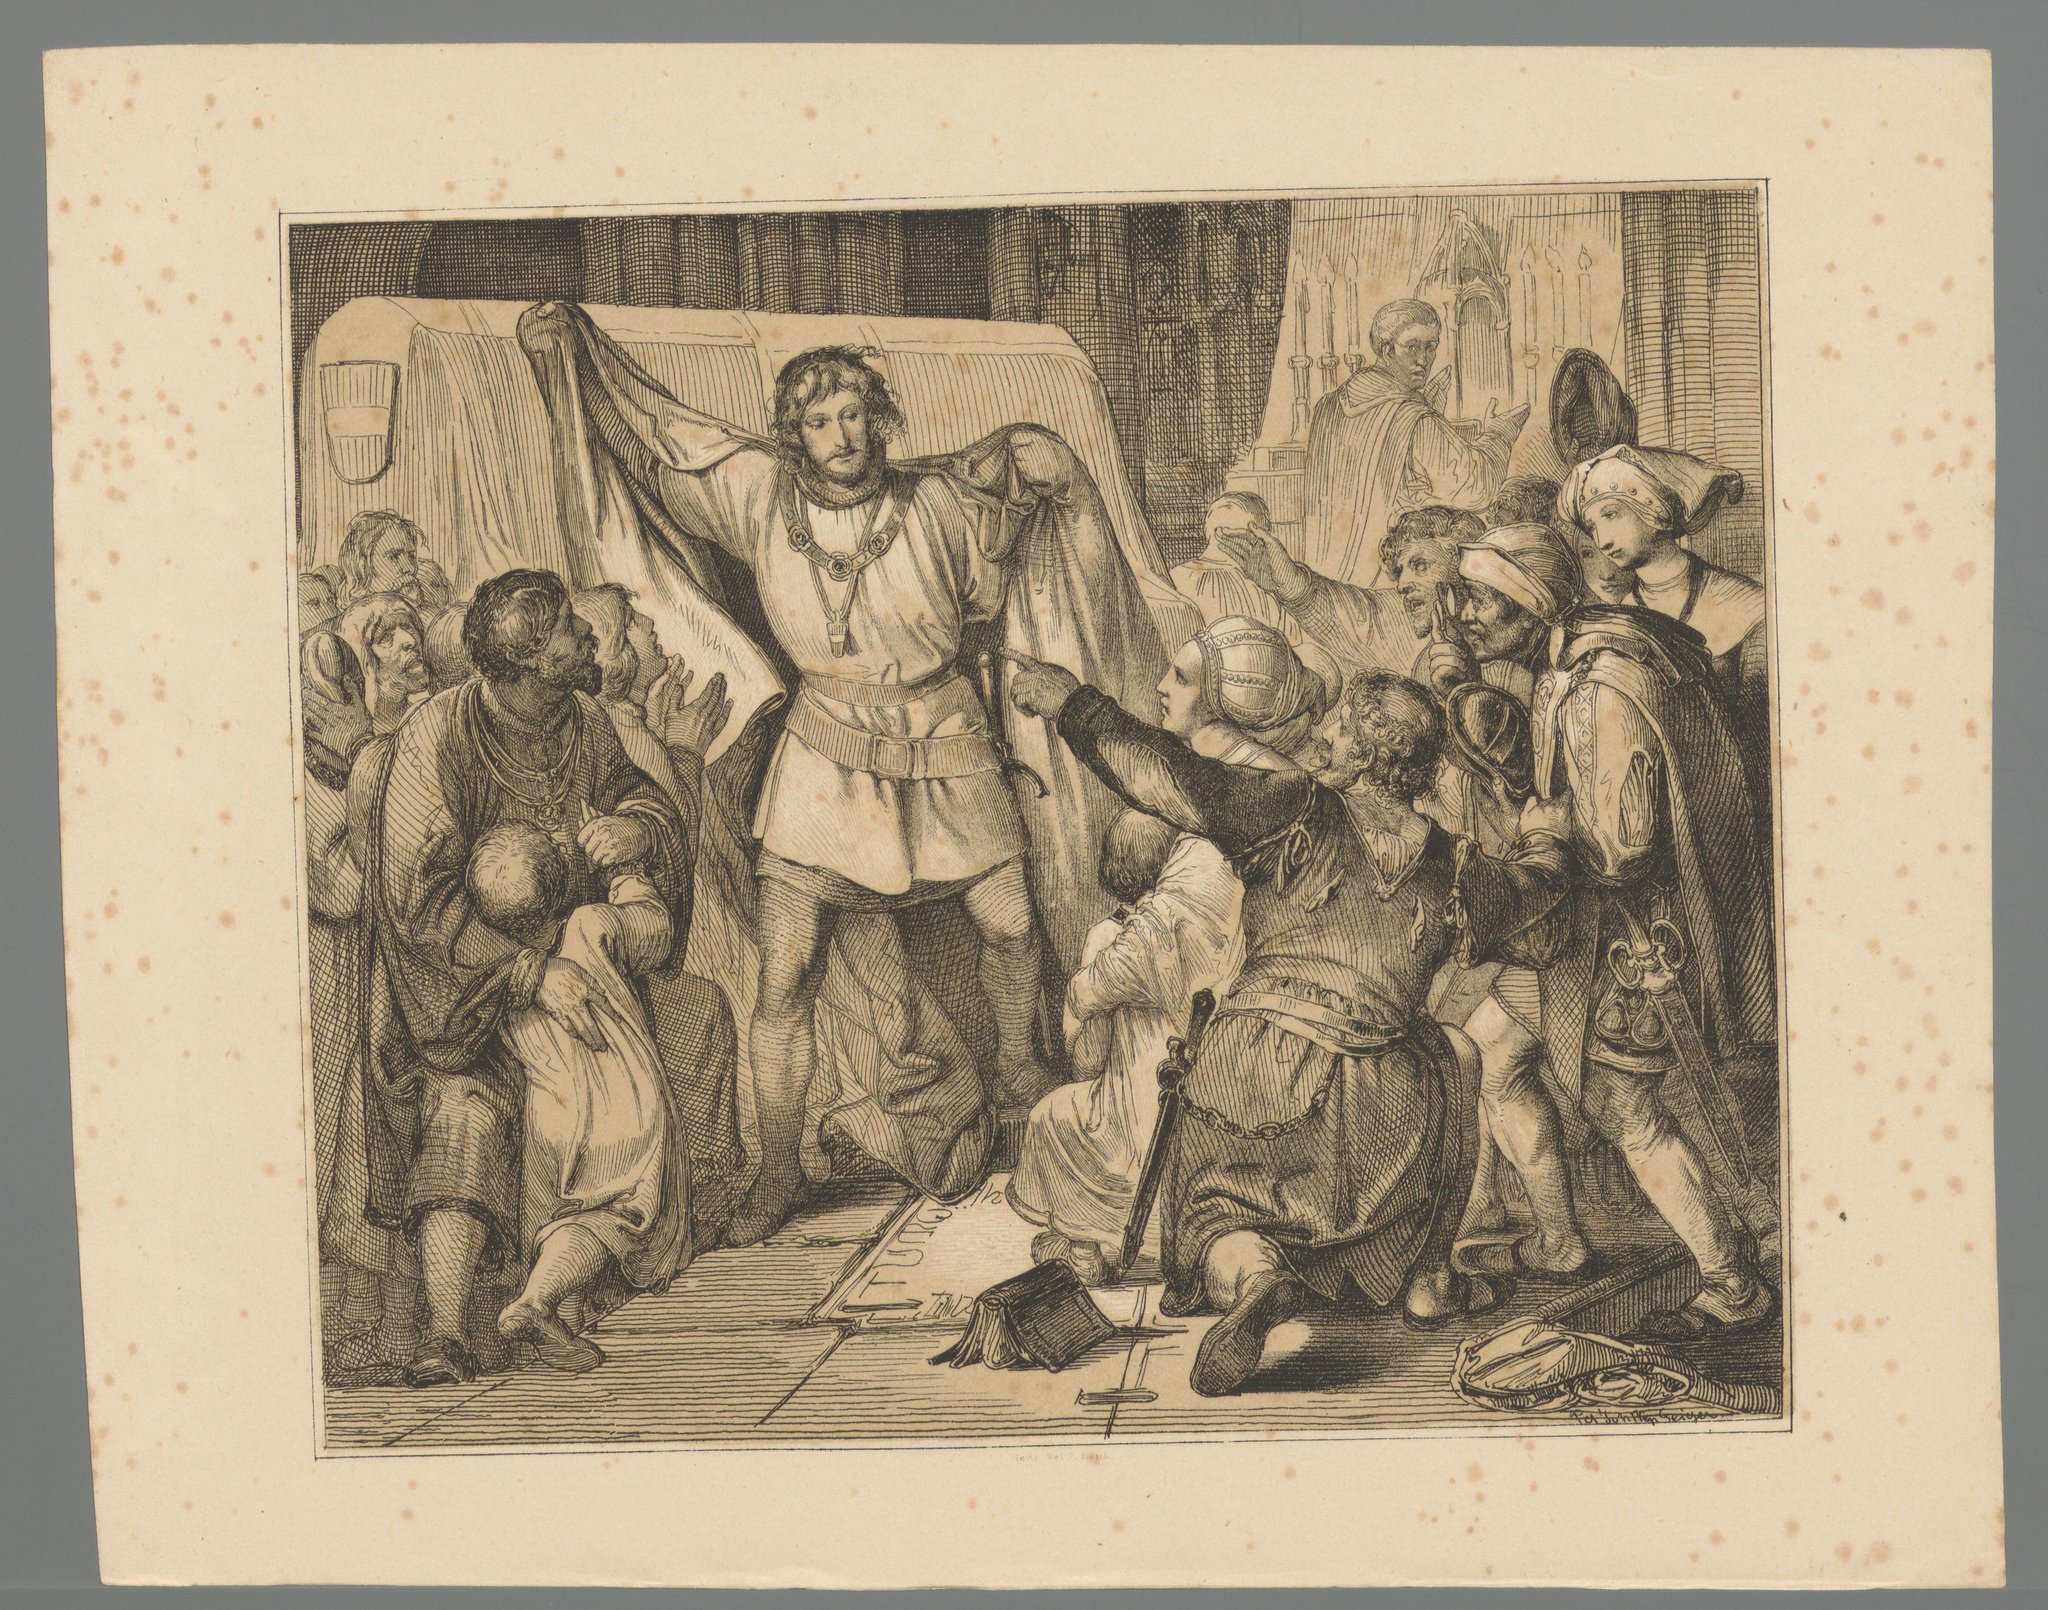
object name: print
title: Man komt onder een doek vandaan in een kerk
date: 1840-1845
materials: paper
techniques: tone lithography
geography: vienna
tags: grave, tomb, interior of church, hiding, hiding oneself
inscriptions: collector's mark: Lugt 2228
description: Prent maakt deel uit van een serie met historische taferelen. Over deze serie is verder niets bekend. Het betreft mogelijk scènes uit het leven van een koning/heilige.